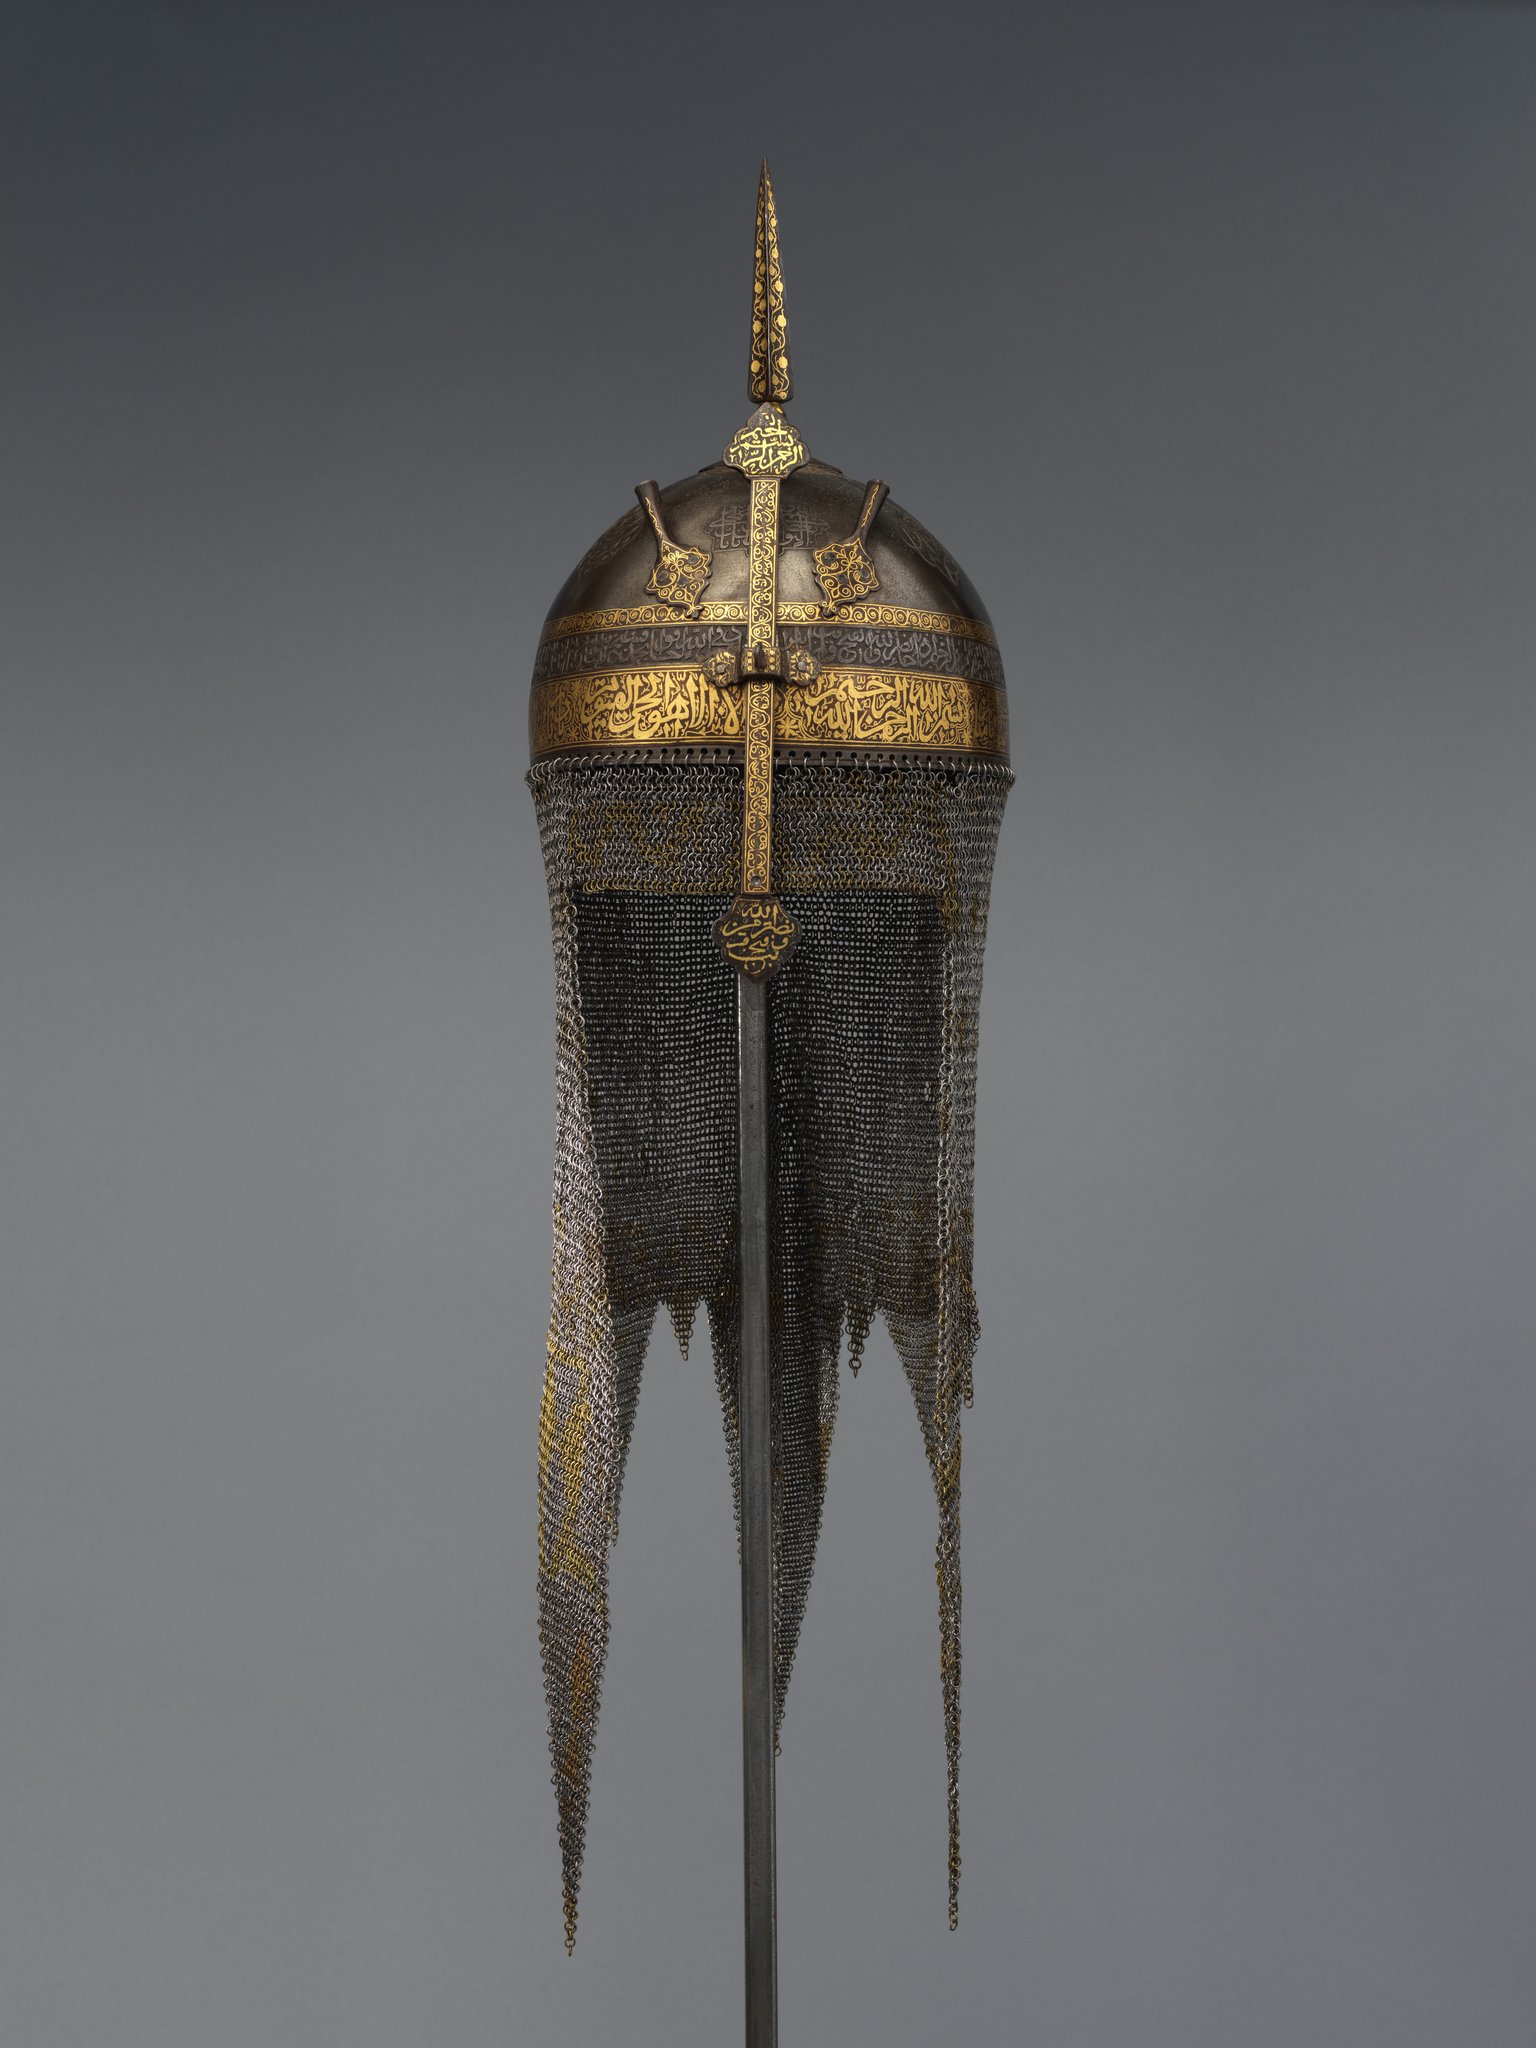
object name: helmet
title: Helmet with Talismanic Inscriptions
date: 1701-1833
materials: gold, steel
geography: iran